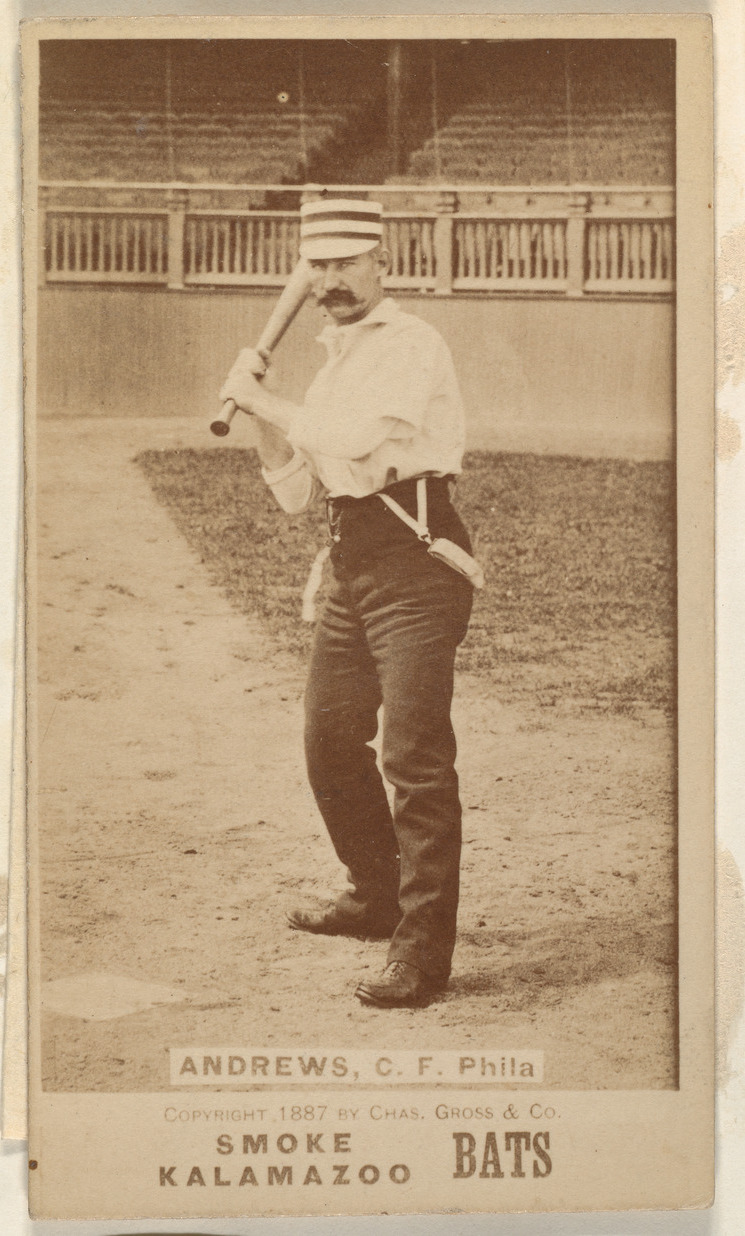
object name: baseball card, photograph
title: Andrews, Center Field, Philadelphia, from the Kalamazoo Bats series (N690) issued by Chas. Gross & Co. to promote Kalamazoo Bats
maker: chas. gross & co.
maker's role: publisher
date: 1887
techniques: albumen silver print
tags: men,portraits,baseball,athletes